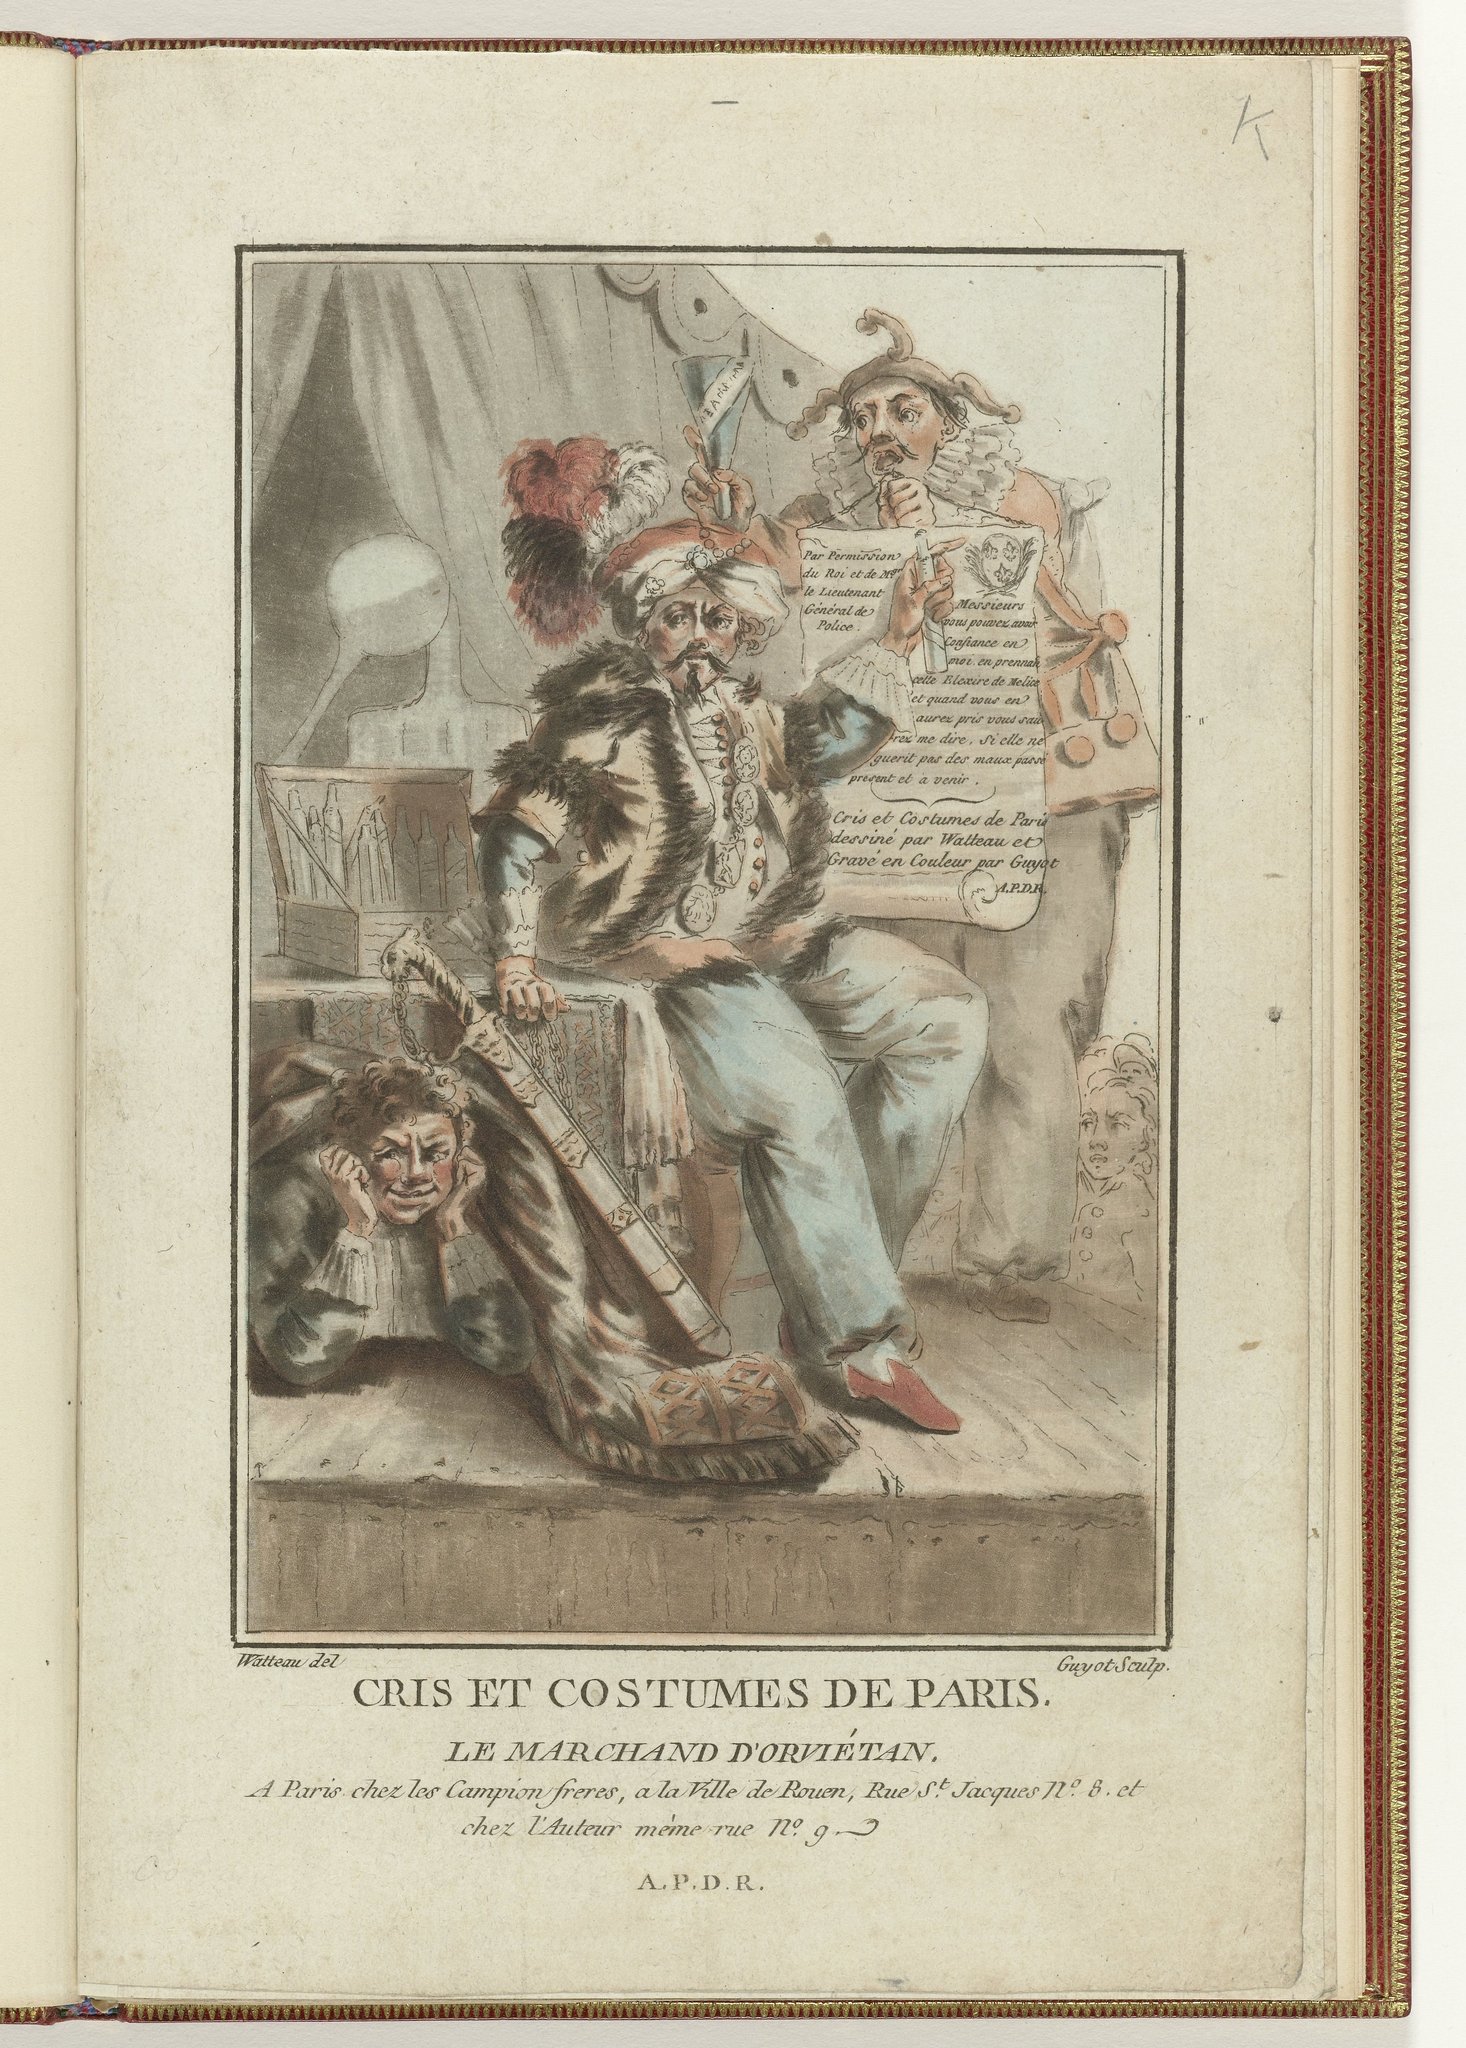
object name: titelprent, frontispice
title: Le Marchand d'Orvietan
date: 1786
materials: paper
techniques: aquatint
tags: head-gear: turban (+ men's clothes), clothes, costume (+ men's clothes), 'cris de paris', cries of london, etc.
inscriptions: signature: ‘Guyot sculp.’, signature: ‘Watteau del.’, title: ‘CRIS ET COSTUMES DE PARIS / Le Marchand d'Orvietan’, address: ‘les frères Campion a la Ville de Rouen’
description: Titelprent: koopman die elixers verkoopt. Hij zit op een tafel op een podium, gekleed in kort bontjasje, tulband op het hoofd. Naast hem op tafel een kistje met flesjes en een retort. Tegen de tafel staat zijn kromzwaard. Onder de tafel ligt een jongeman die de beschouwer aankijkt. Achter hem een clown met uitgerold document waarop staat vermeld dat de koopman toestemming heeft zijn waren te verkopen. Onderaan het pamflet de titel van de serie: Cris et costumes de Paris dessiné par Watteau et Gravé en Couleur par Guyot.